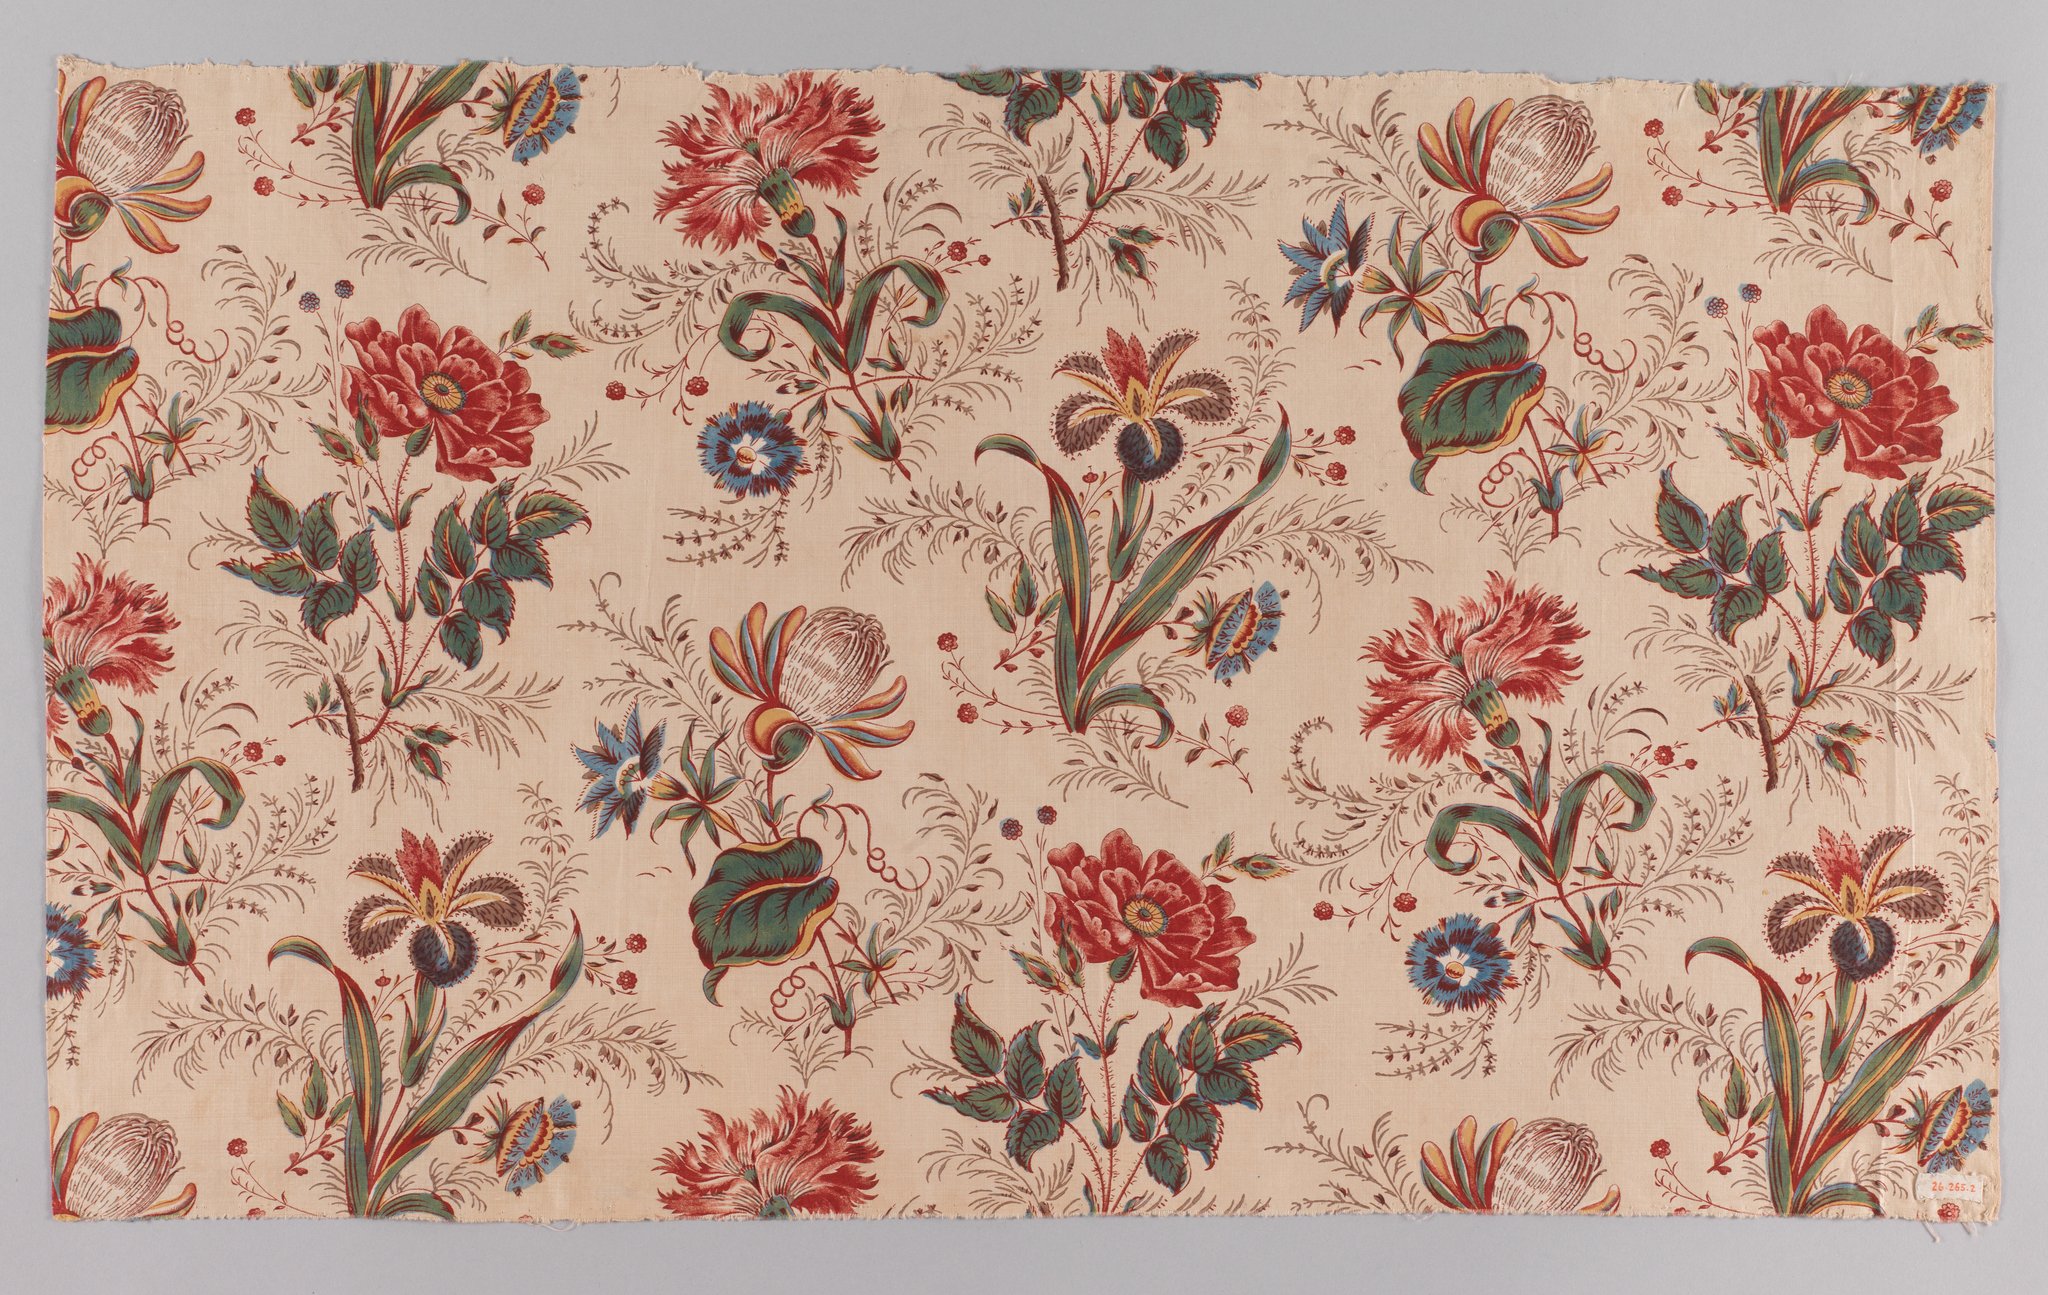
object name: fragment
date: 1830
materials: cotton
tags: flowers